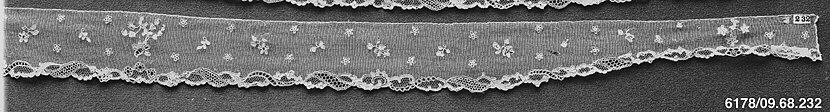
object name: sleeve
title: Sleeve (one of a pair)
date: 1701-1800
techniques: lace